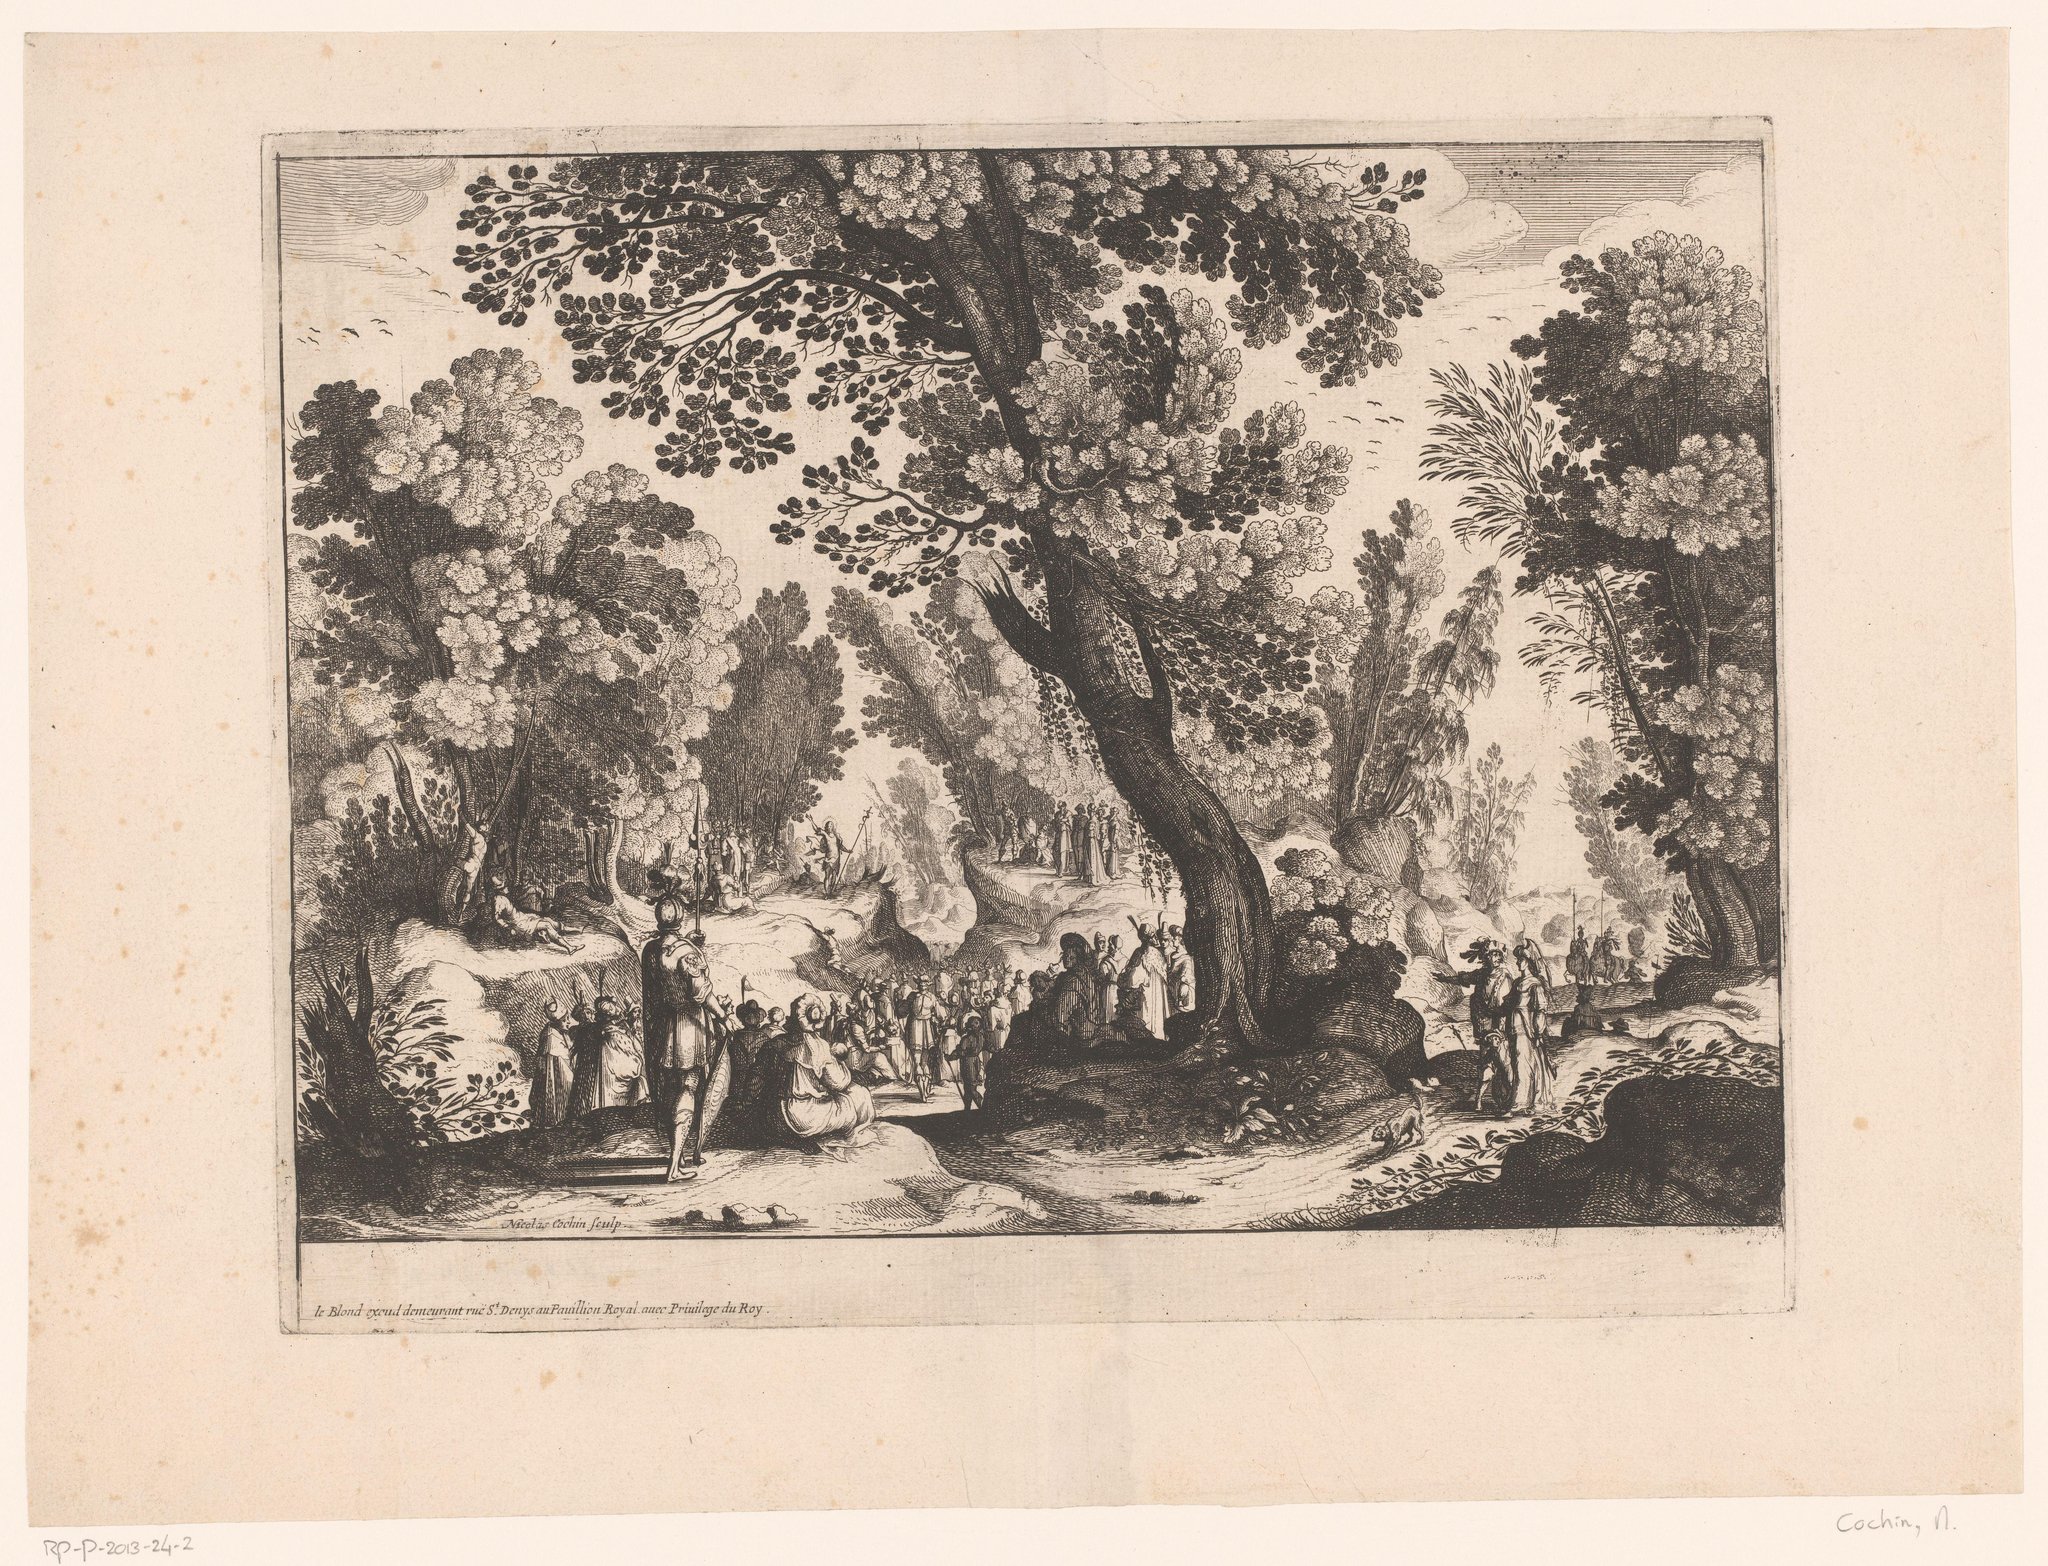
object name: print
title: Landschap met de prediking van Johannes de Doper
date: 1620-1686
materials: paper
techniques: etching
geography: france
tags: forest, wood, john the baptist disputing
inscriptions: collector's mark: Lugt 2760, collector's mark: Lugt 2228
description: Landschap met de prediking van Johannes de Doper. Boslandschap met toehoorders op de voorgrond, in de verte de figuur van Johannes de Doper.